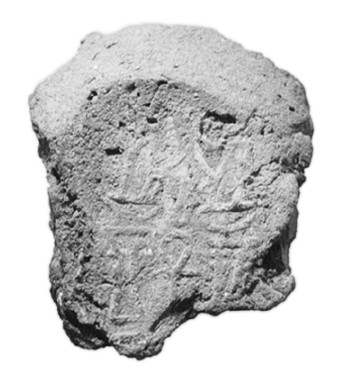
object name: sealing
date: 2030-1640 BCE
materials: clay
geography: egypt